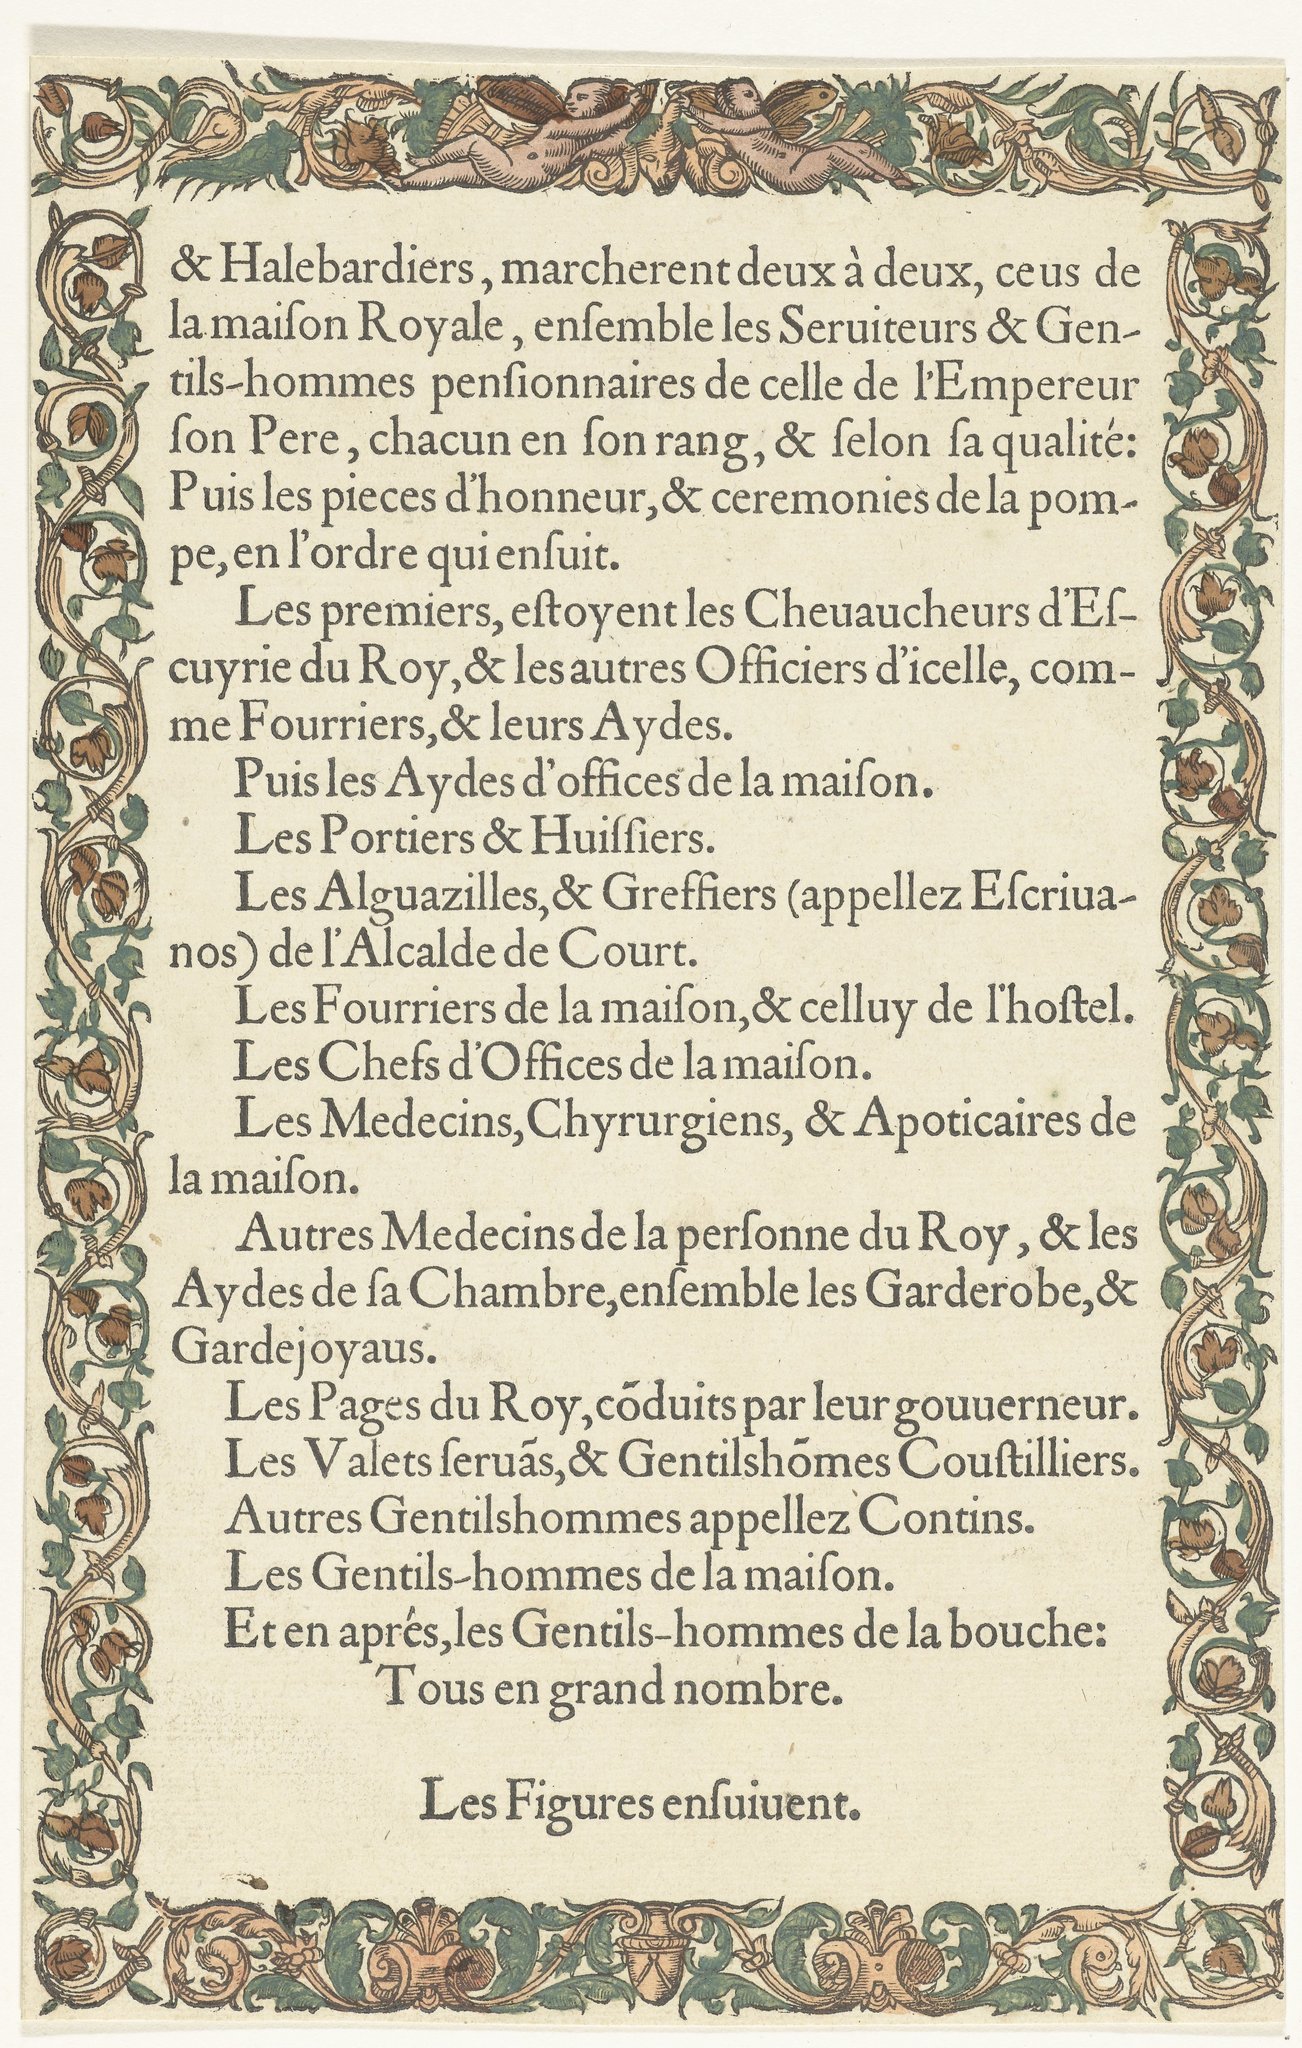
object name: text sheet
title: La magnifique, et sumptueuse Pompe Funebre, faite aus Obseques & Funerailles du tres-grand & tres-victorieus Empereur Charles Cinquième, Celebrées en la Vile de Bruxelles le XXIX. Iour du Mois de Decembre M.D.LVIII. par Philippes Roy Catholique d'Espaignes son Fils.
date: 1559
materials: paper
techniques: hand coloring, letterpress printing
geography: antwerp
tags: ghent, charles v (holy roman emperor and king of spain), brussels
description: Tekstblad bij de Begrafenisoptocht van keizer Karel V, 1558. Tekstblad met titel en beschrijving van de optocht. In ornamentele randen in houtsnede. Vierde blad.